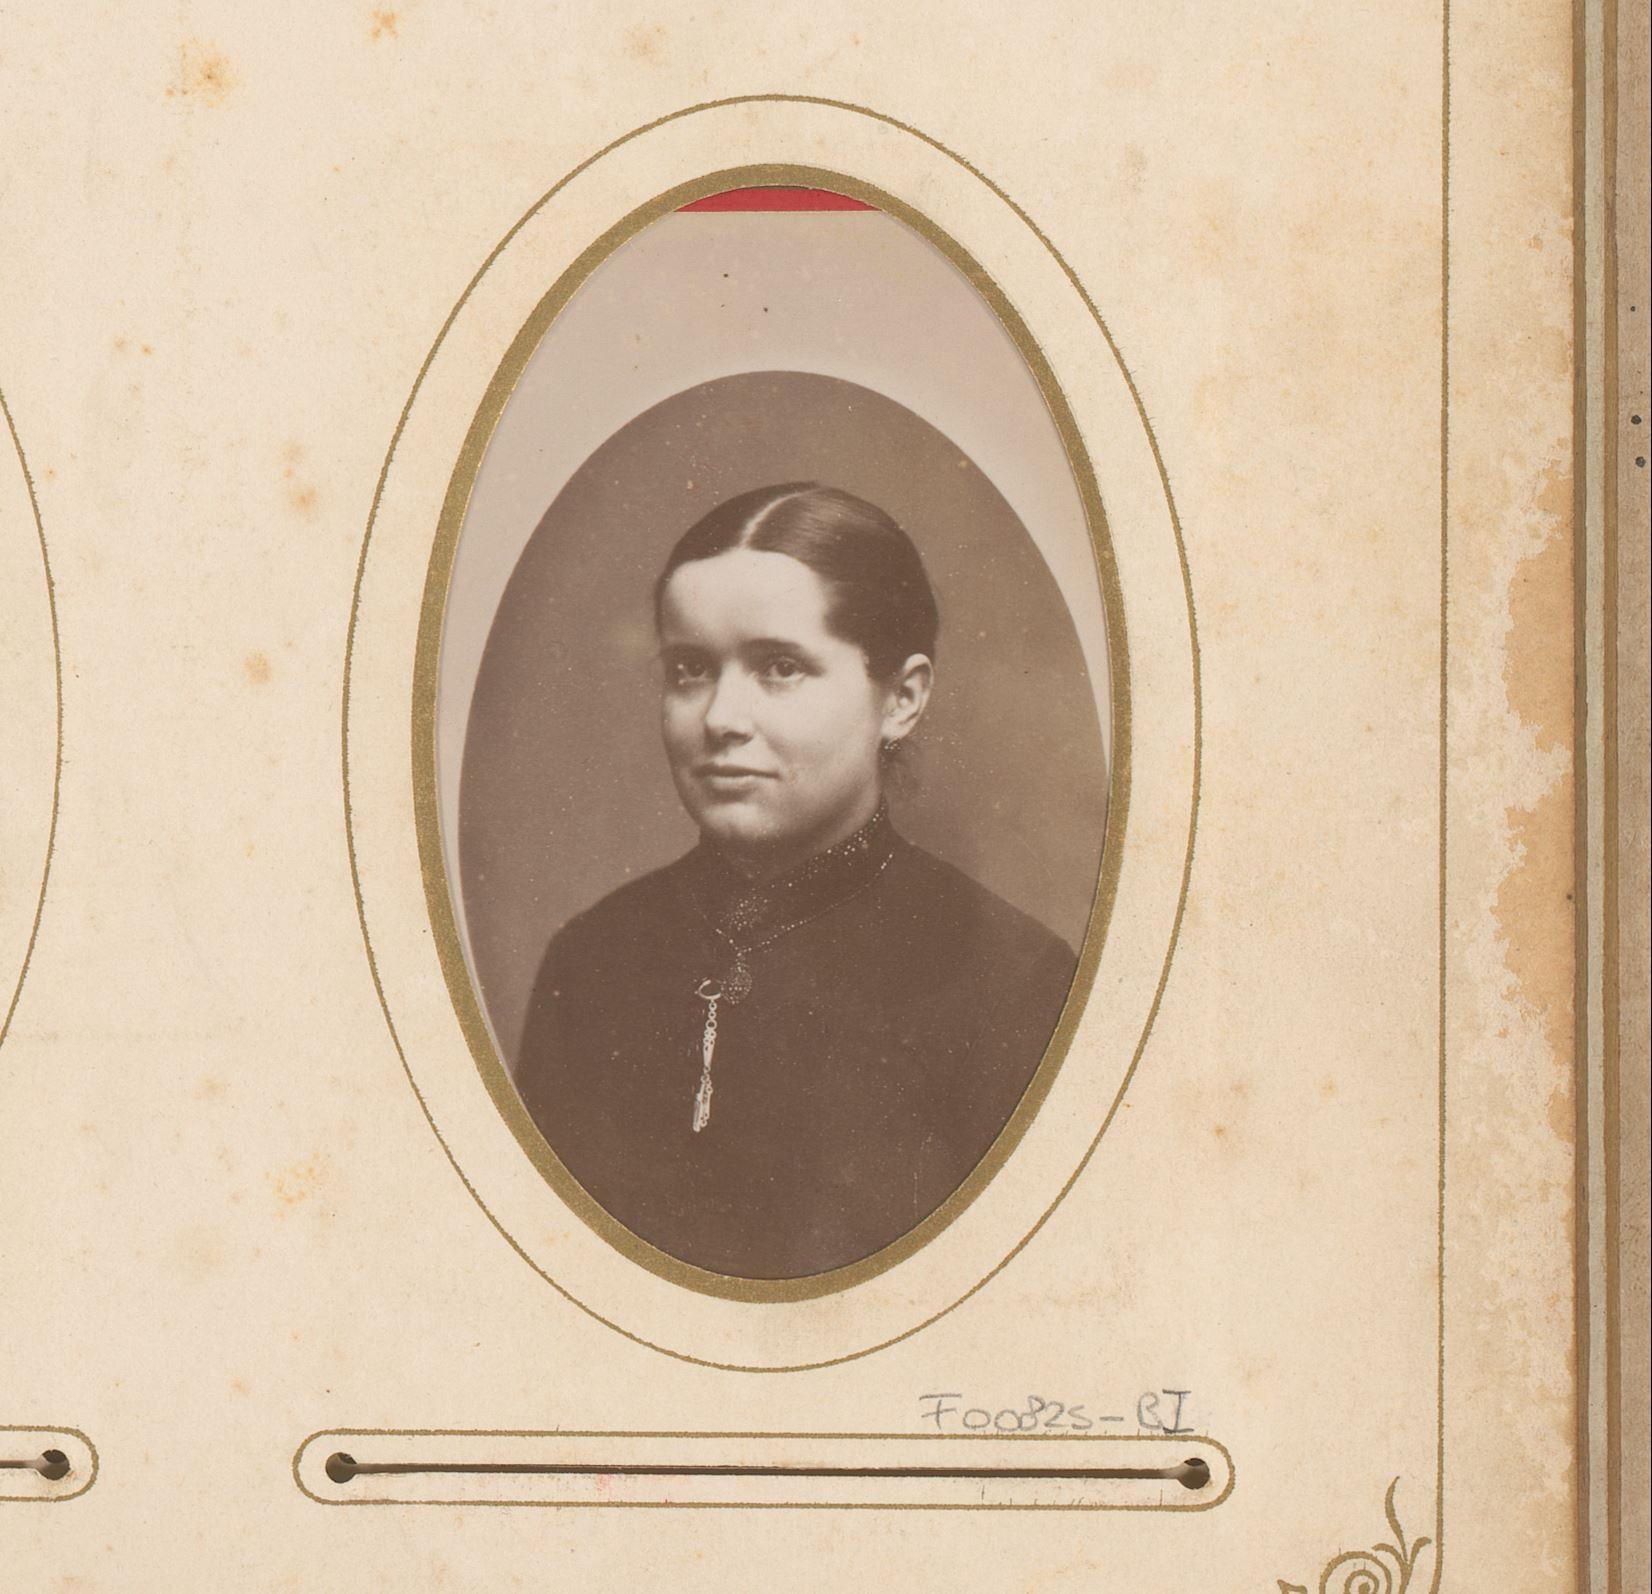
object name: carte de visite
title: Portret van een jonge vrouw met halsketting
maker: marius n.f. rotteveel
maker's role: fotograaf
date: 1881-1887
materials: cardboard, photographic support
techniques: albumen print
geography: haarlem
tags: adolescent, young woman, maiden, historical persons - bb - woman, necklace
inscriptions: inscription: ‘(...)/ Marius F. N. Rotteveel/ Hofphotograaf/ Haarlem/ Spaarne 71.’